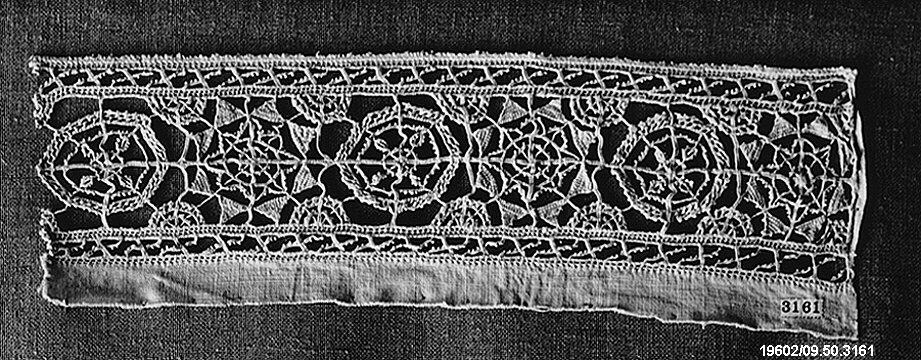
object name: strip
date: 1601-1700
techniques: embroidery